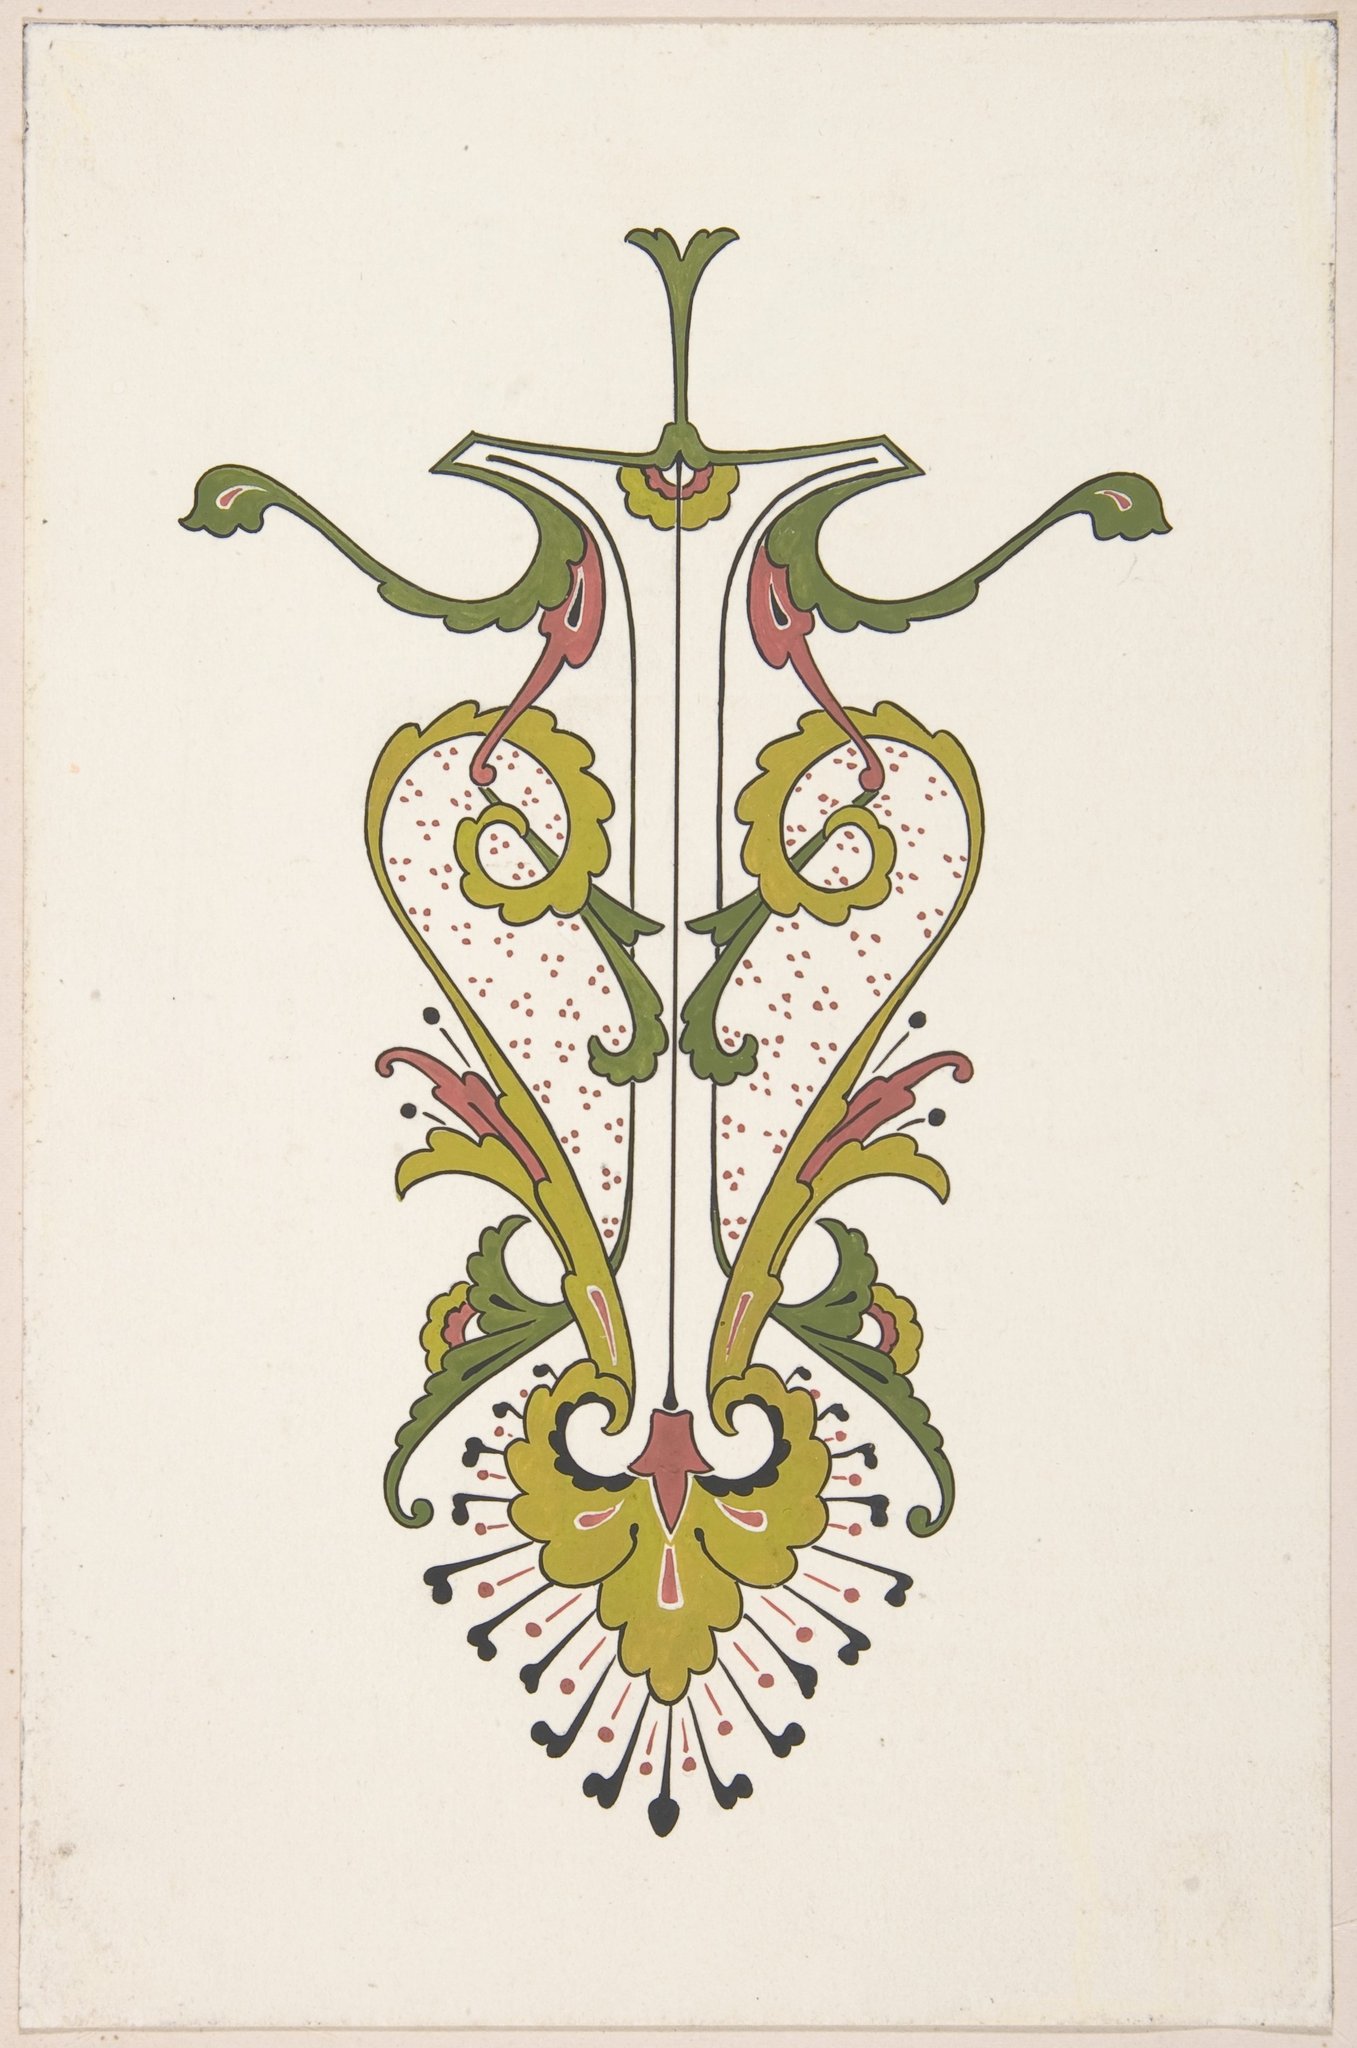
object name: drawing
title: Design drawing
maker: christopher dresser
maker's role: designer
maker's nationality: british, scottish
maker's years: 1834-1904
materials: gouache, graphite, ink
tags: ornament